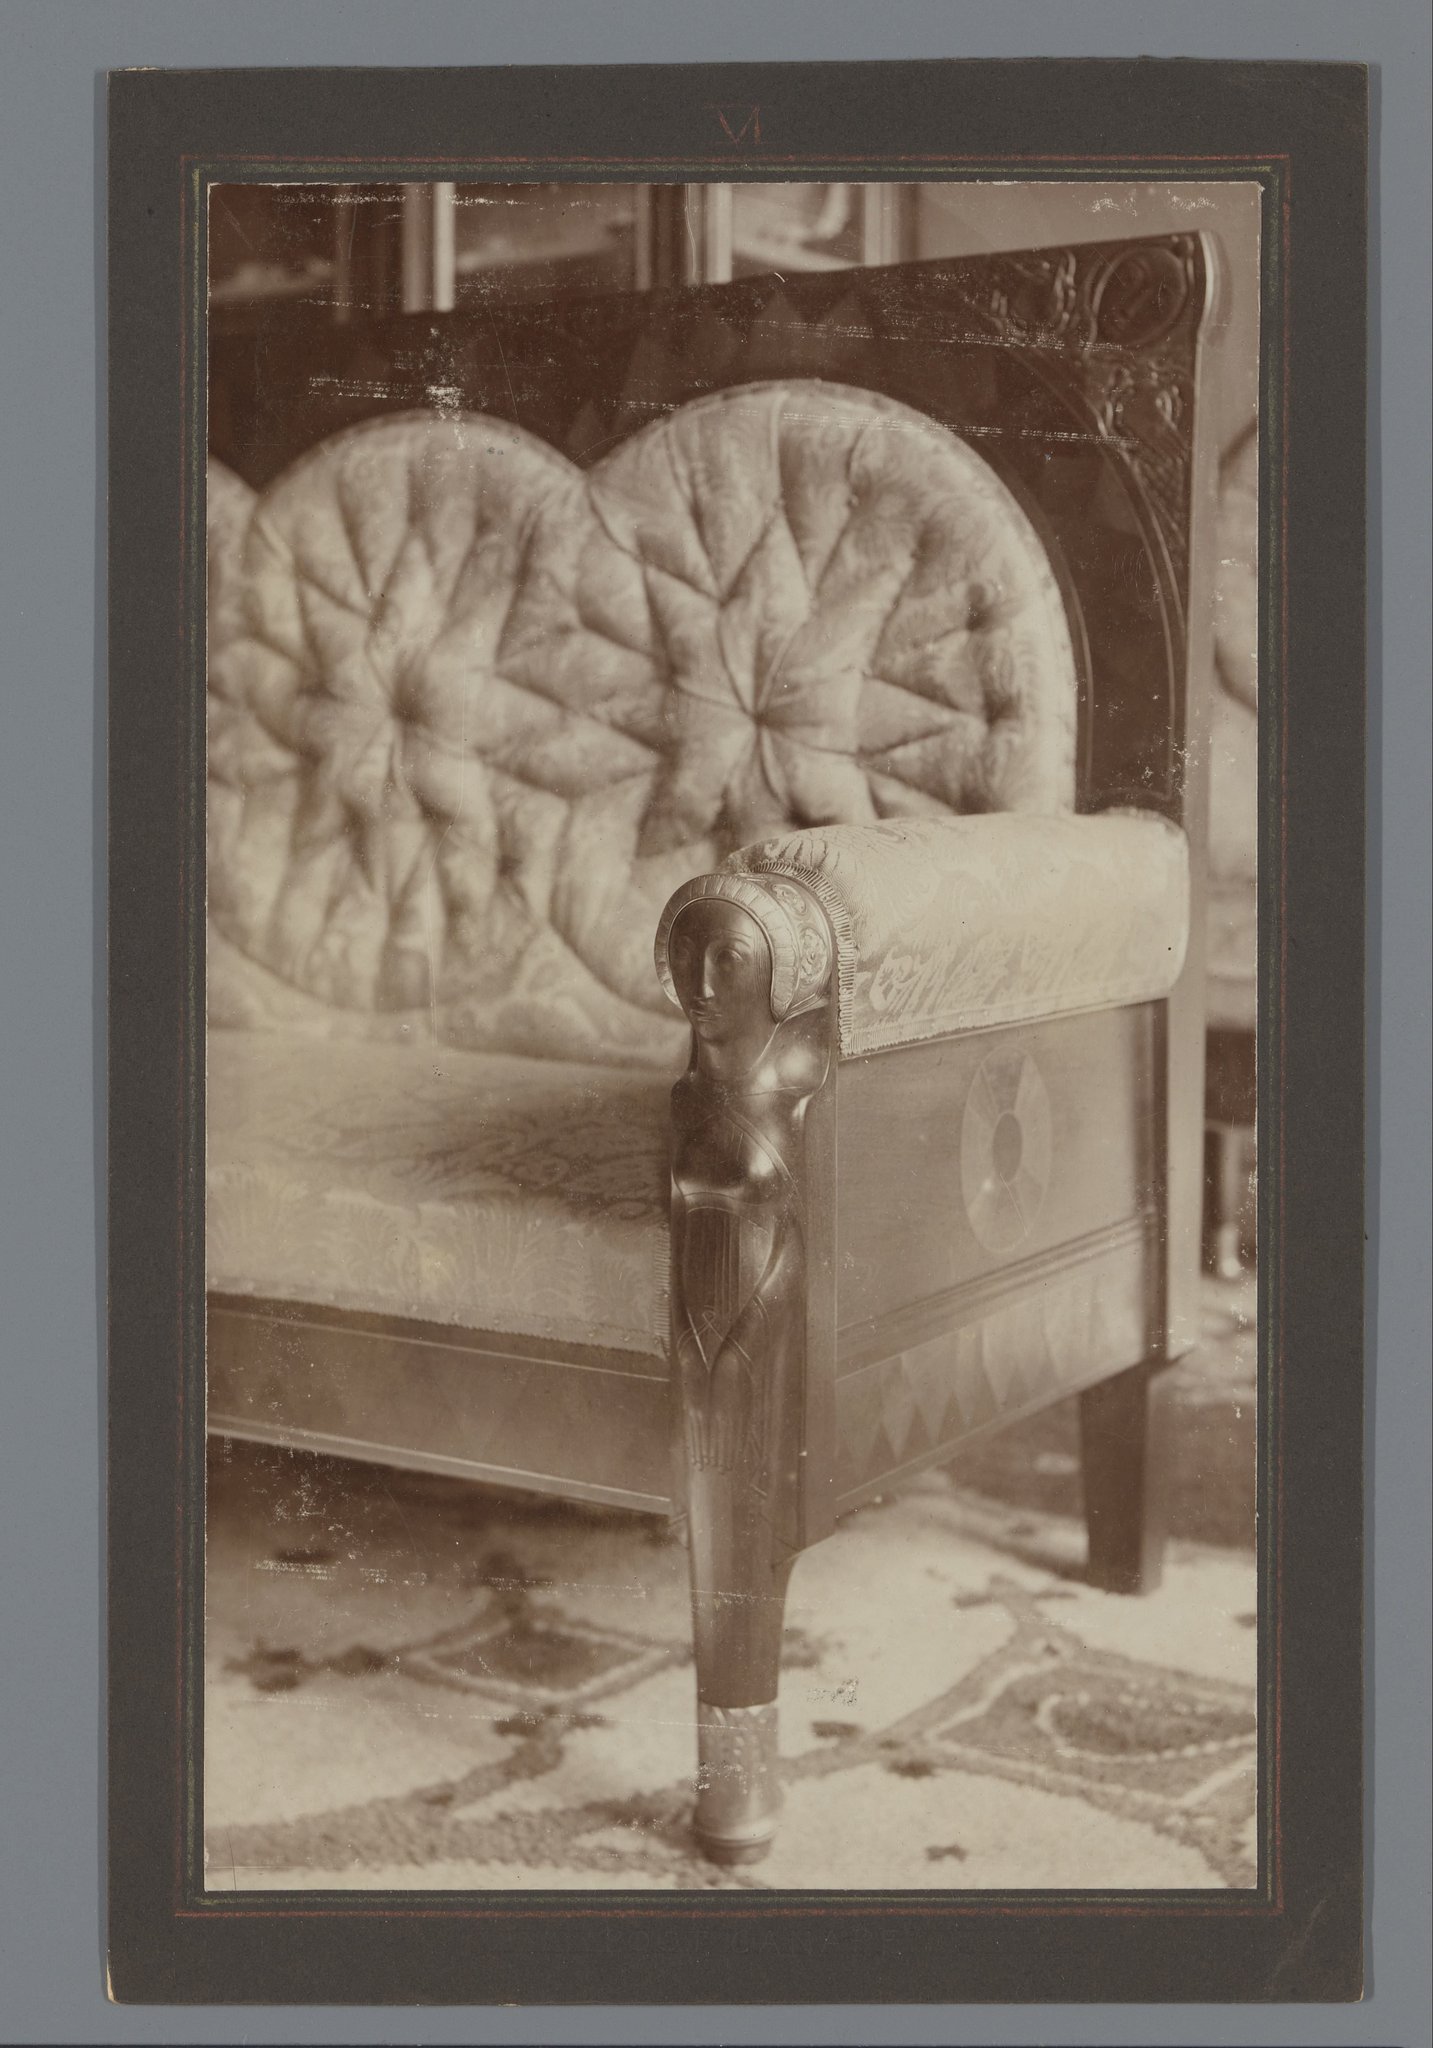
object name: photograph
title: Detail van een bank naar ontwerp van Mathieu Lauweriks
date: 1910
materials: cardboard, photographic support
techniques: collodion silver print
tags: bench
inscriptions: inscription: ‘salon-ameublement uitgevoerd in cuba-mahoni-/ hout met verguld en geciseleerd koperwerk,/ voor den heer J. P. W. Schuurman, Den Haag./ Ontworpen door J. L. M. Lauweriks, architect./ Uitgevoerd door de firma Wed. C. Nederkoorn,/ meubelmaker te Haarlem. + Beelhouwwerk/ van M. J. Hack te Amsterdam. + Koperwerk van/ F. Zwollo, Amsterdam +++++++++’, annotation: ‘detail canapé/ JM Lauweriks - Ma[...]ts 18/ Düsseldorf’, number: ‘VI’